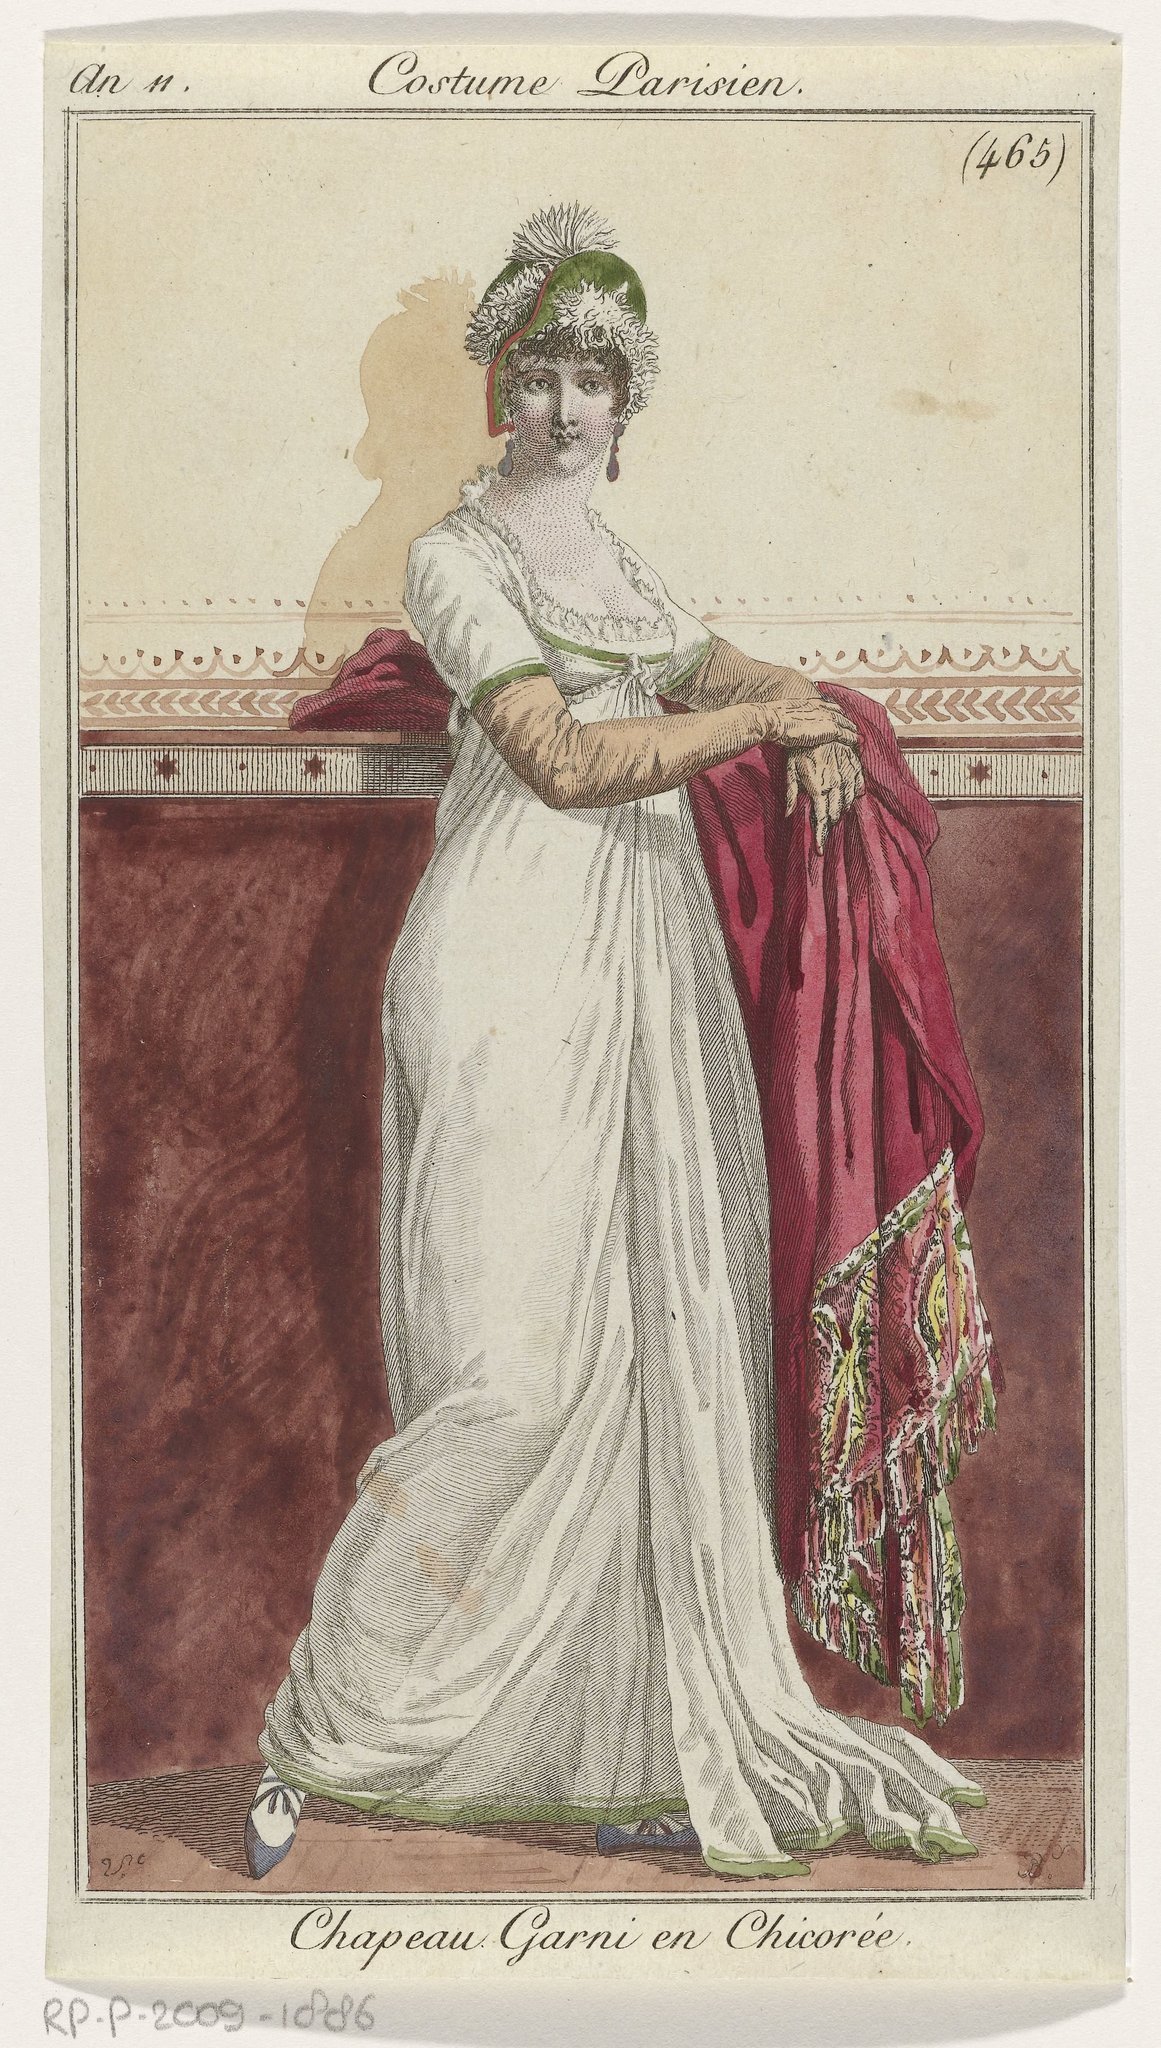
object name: fashion print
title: Journal des Dames et des Modes, Costume Parisien, 25 avril 1803. An 11, (465): Chapeau garni en Chicorée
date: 1803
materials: paper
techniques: engraving, hand coloring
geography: paris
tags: ear-rings (+ women's clothes), gloves, mittens (long gloves) (+ women's clothes), clothing for the upper part of the body (shawl) (+ women's clothes), fashion plates, head-gear: hat (+ women's clothes), shoes, sandals (+ women's clothes), dress, gown (+ women's clothes)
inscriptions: caption: ‘Chapeau garni en Chicorée’, title: ‘Costume Parisien’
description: Vrouw met op het hoofd een hoed versierd met 'chicorée'. Zij draagt een japon met decolleté, korte mouwen, hoge taille en sleepje. Verdere accessoires: lange handschoenen, sjaal afgezet met franjes, platte schoenen met bandjes over de wreef. De prent maakt deel uit van het modetijdschrift Journal des Dames et des Modes, uitgegeven door Pierre de la Mésangère, Parijs, 1797-1839.